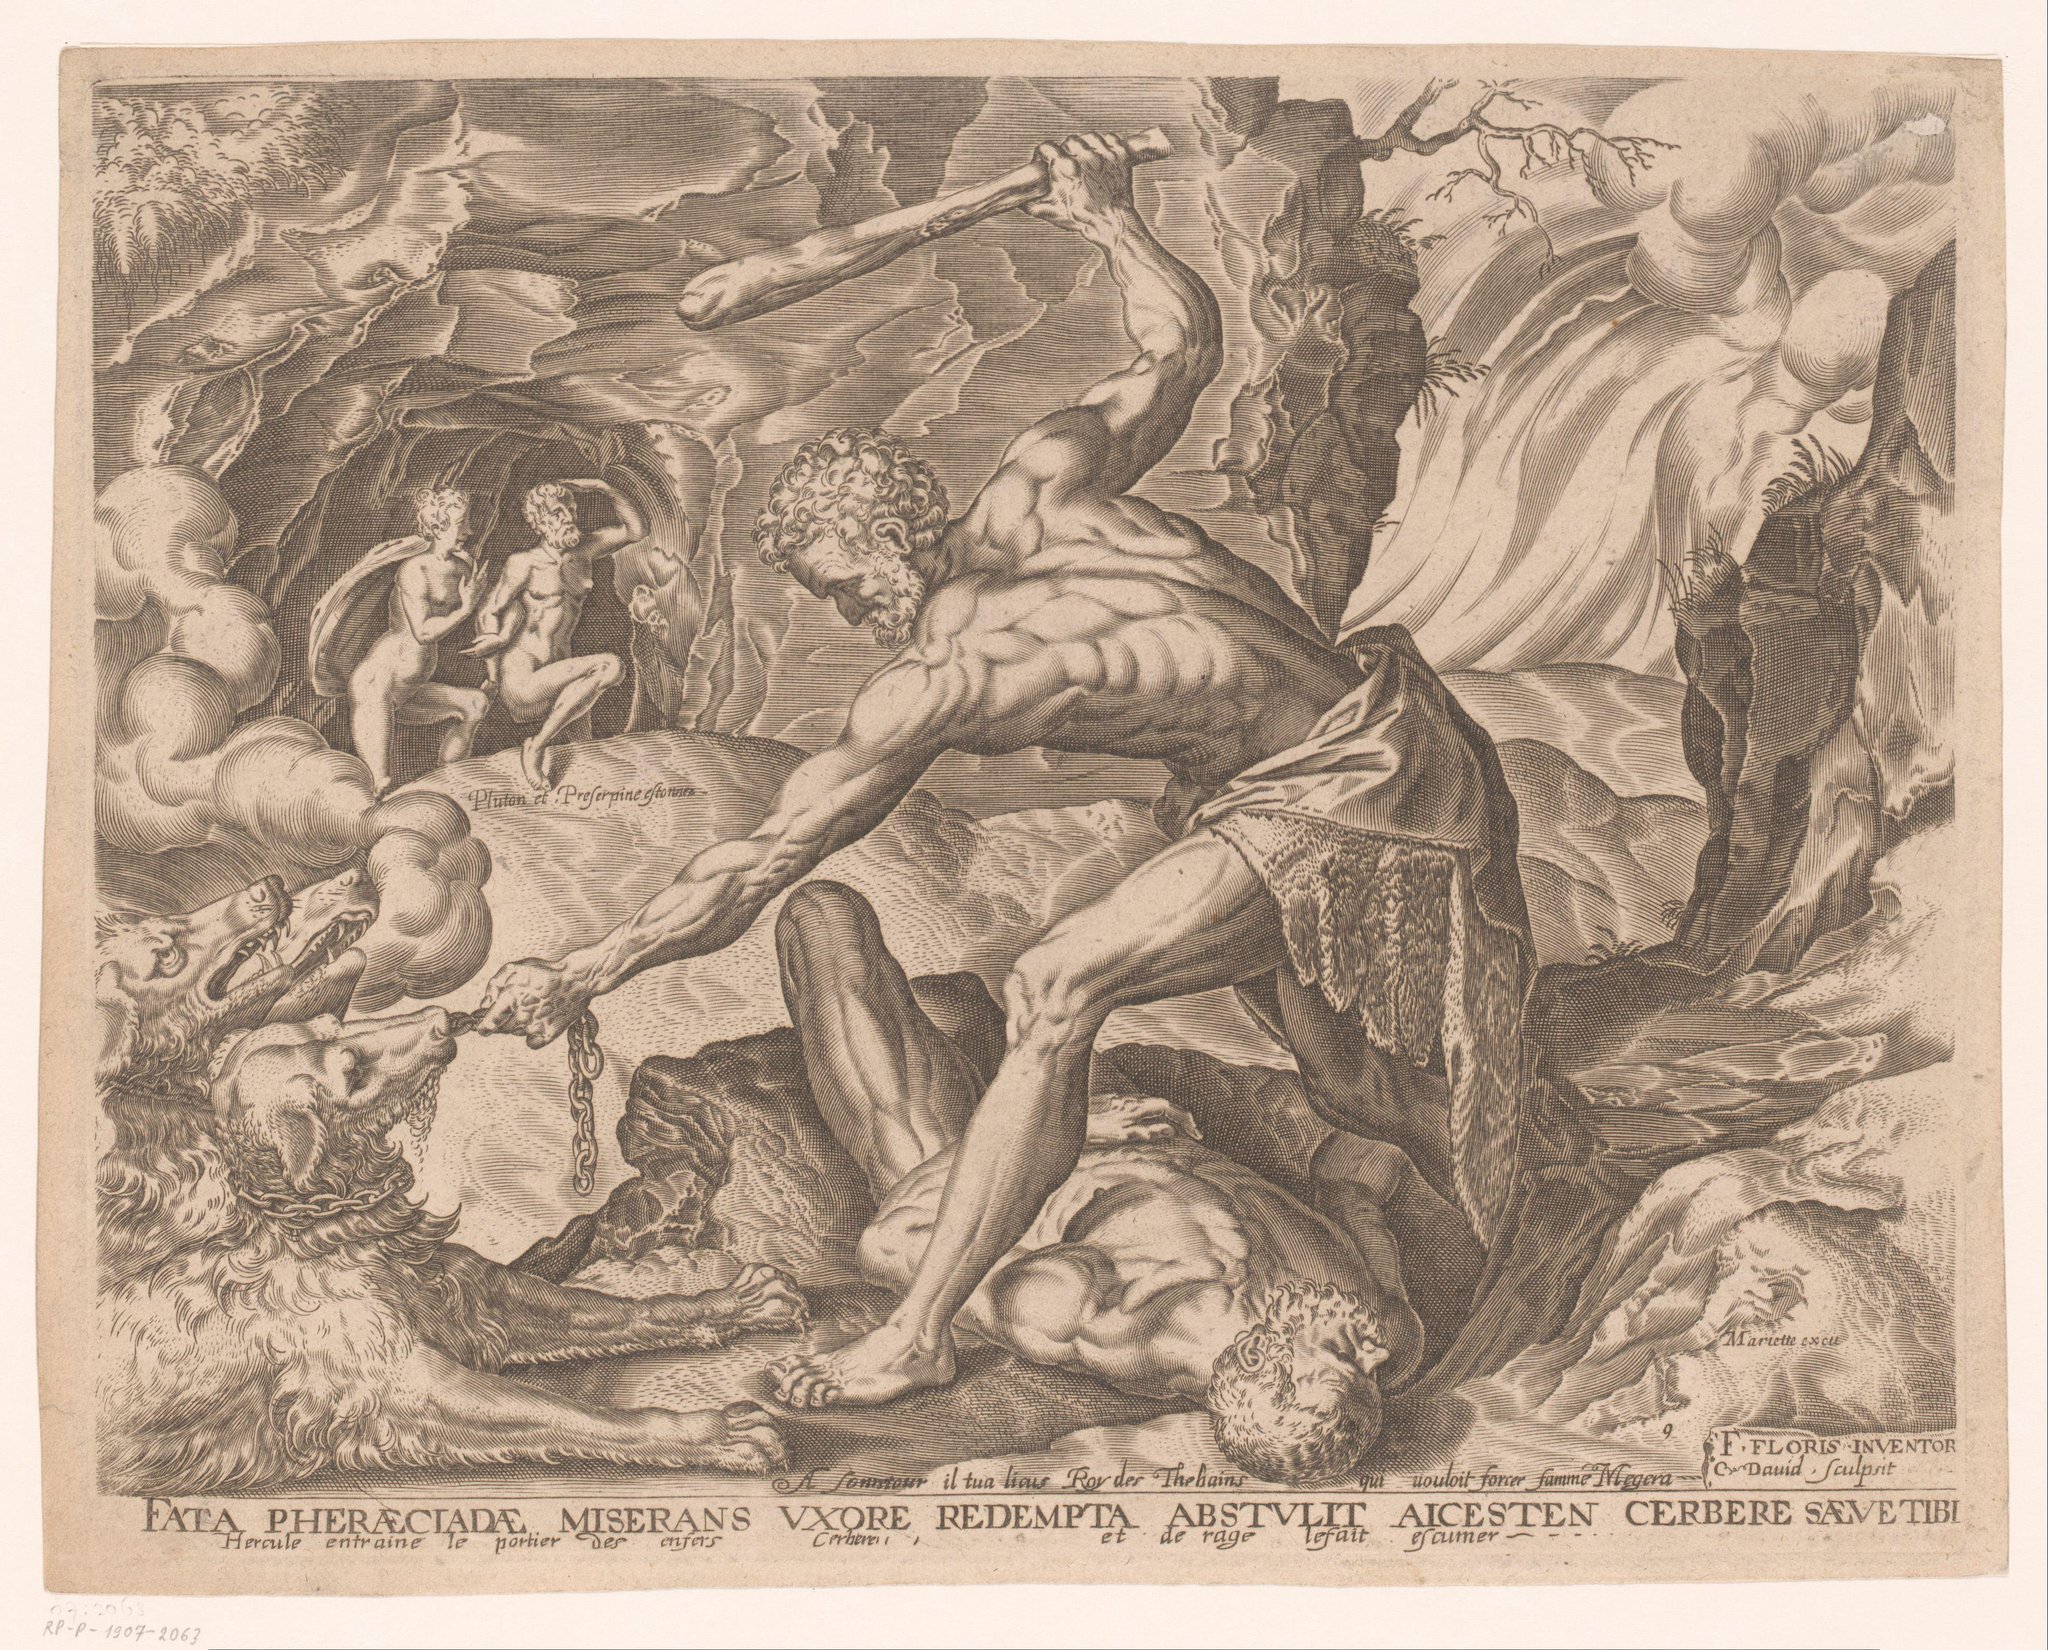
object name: print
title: Hercules bedwingt Cerberus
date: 1613-1638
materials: paper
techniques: engraving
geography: paris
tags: hercules before pluto and proserpina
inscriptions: collector's mark: Lugt 2228